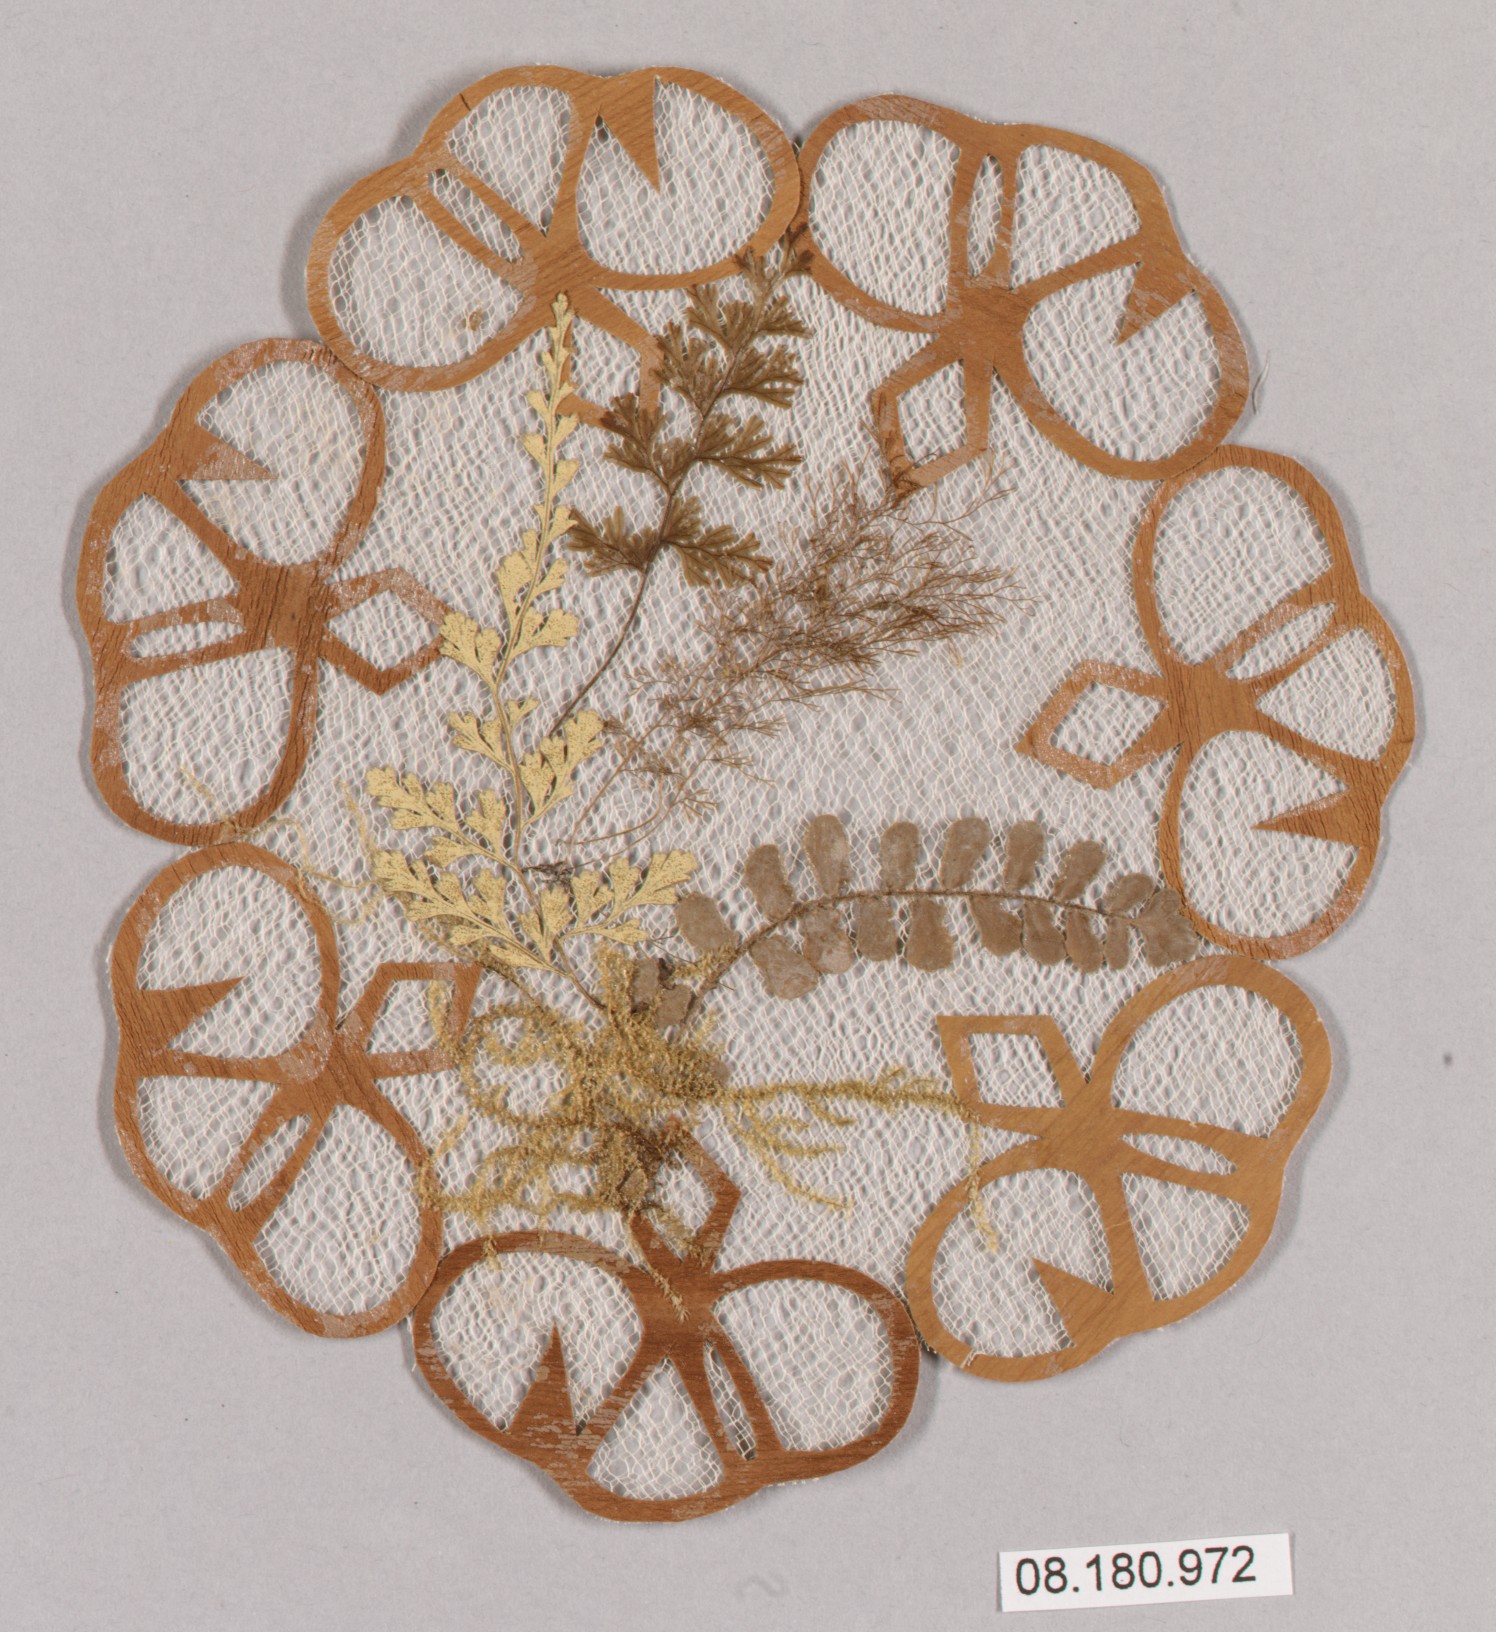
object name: doily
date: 1801-1900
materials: lace